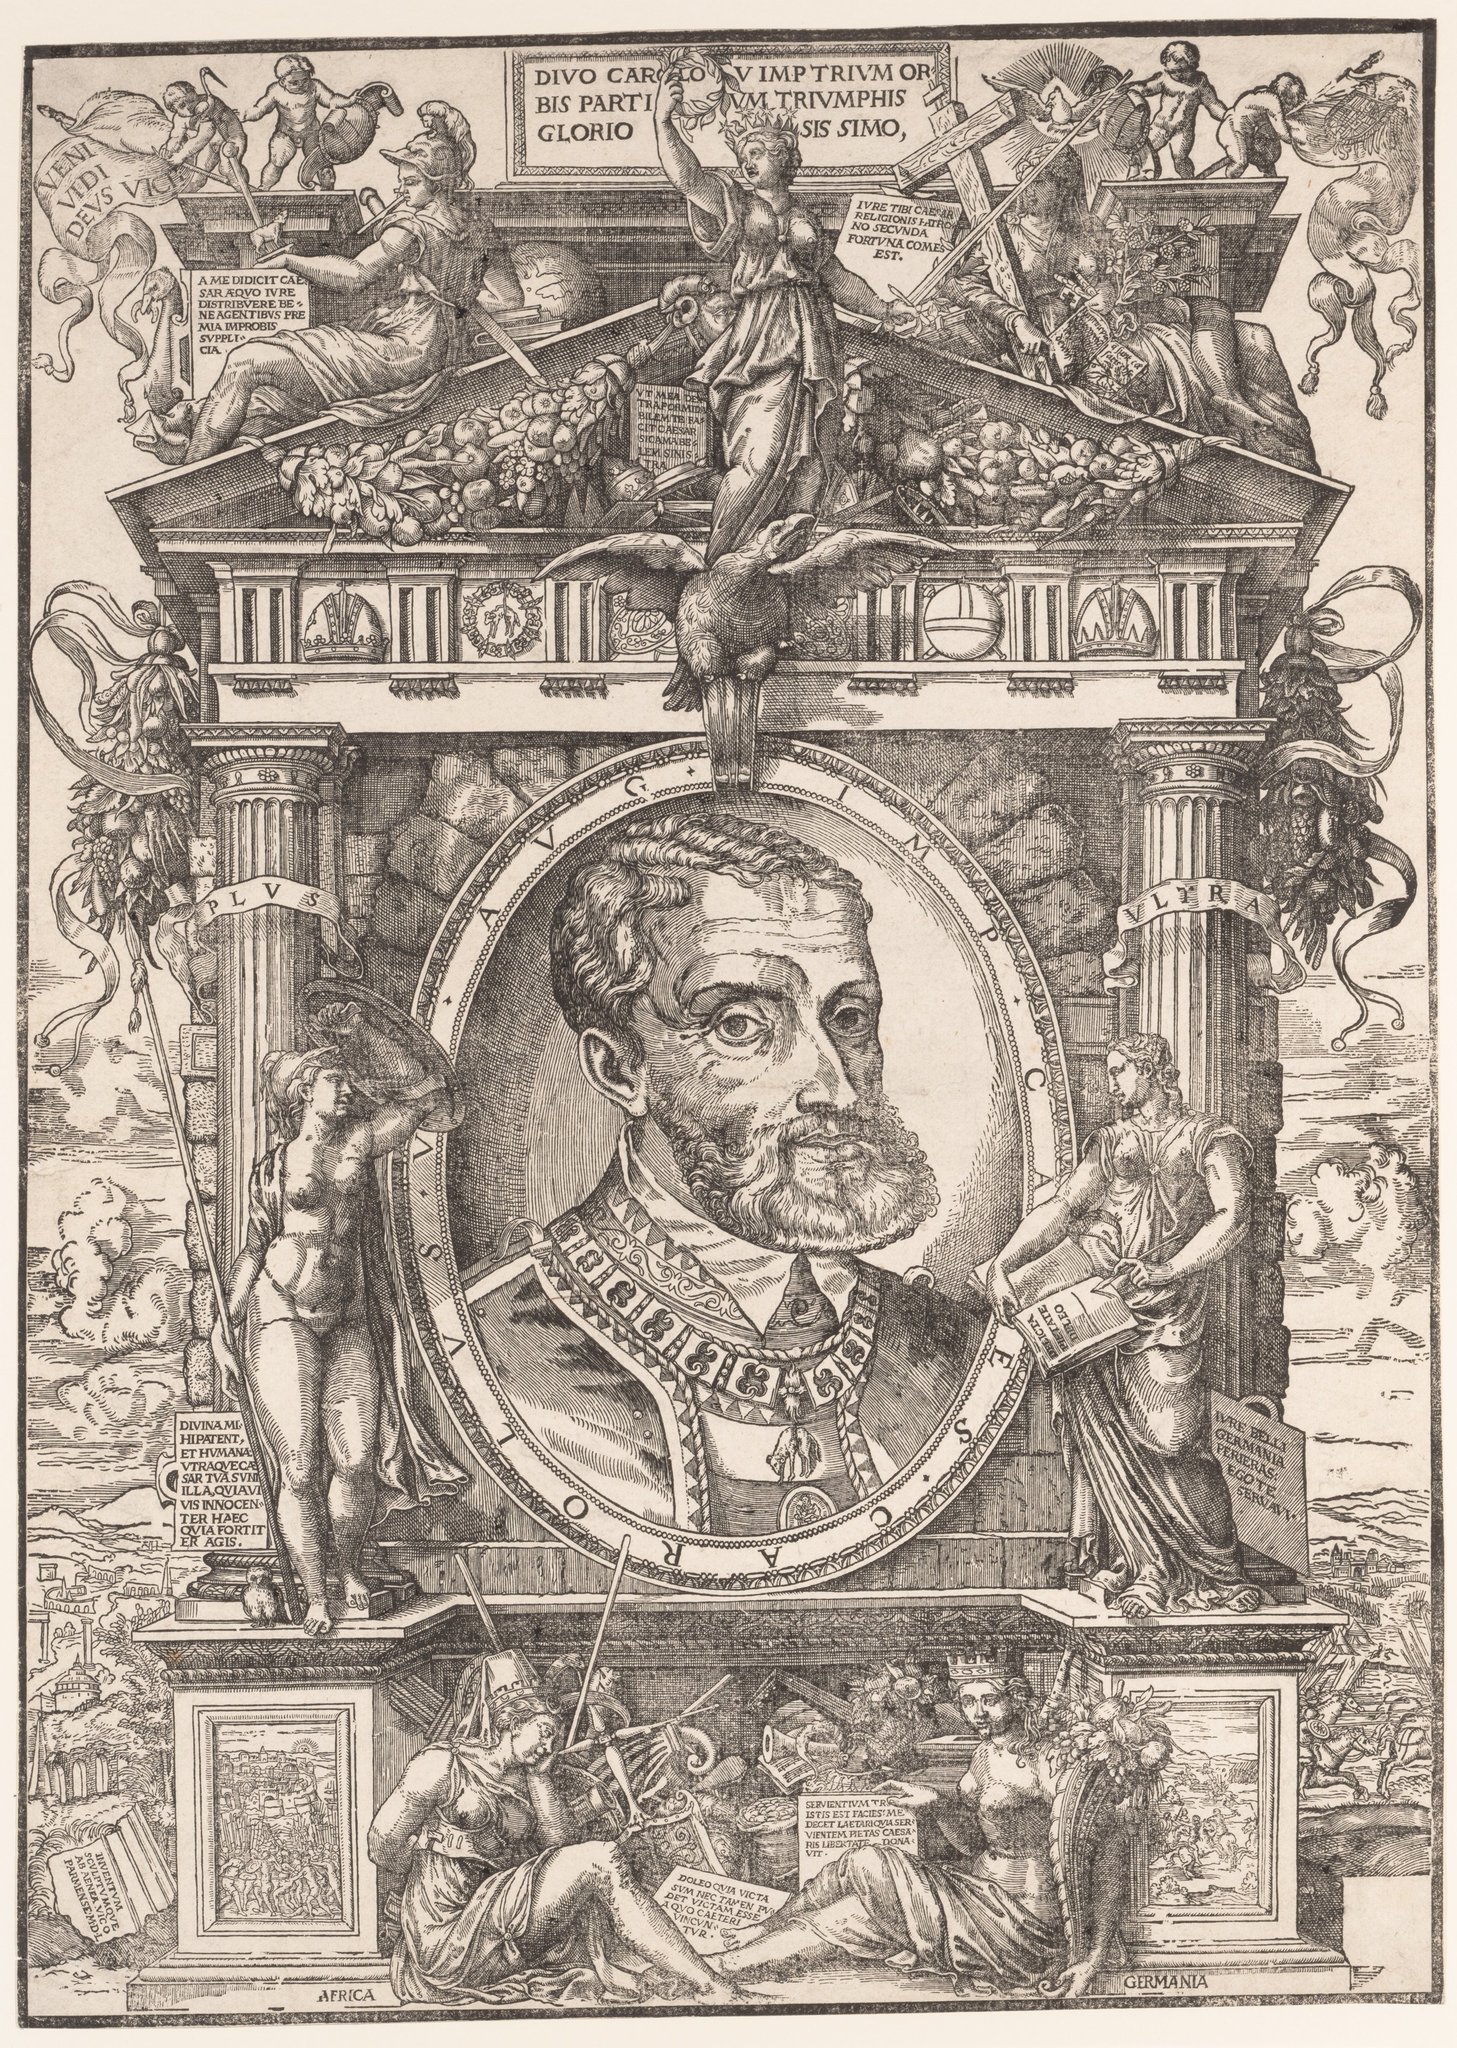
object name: print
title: Emperor Charles V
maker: Anonymous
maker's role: artist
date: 1550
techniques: woodcut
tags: birds,men,portraits,women,cross